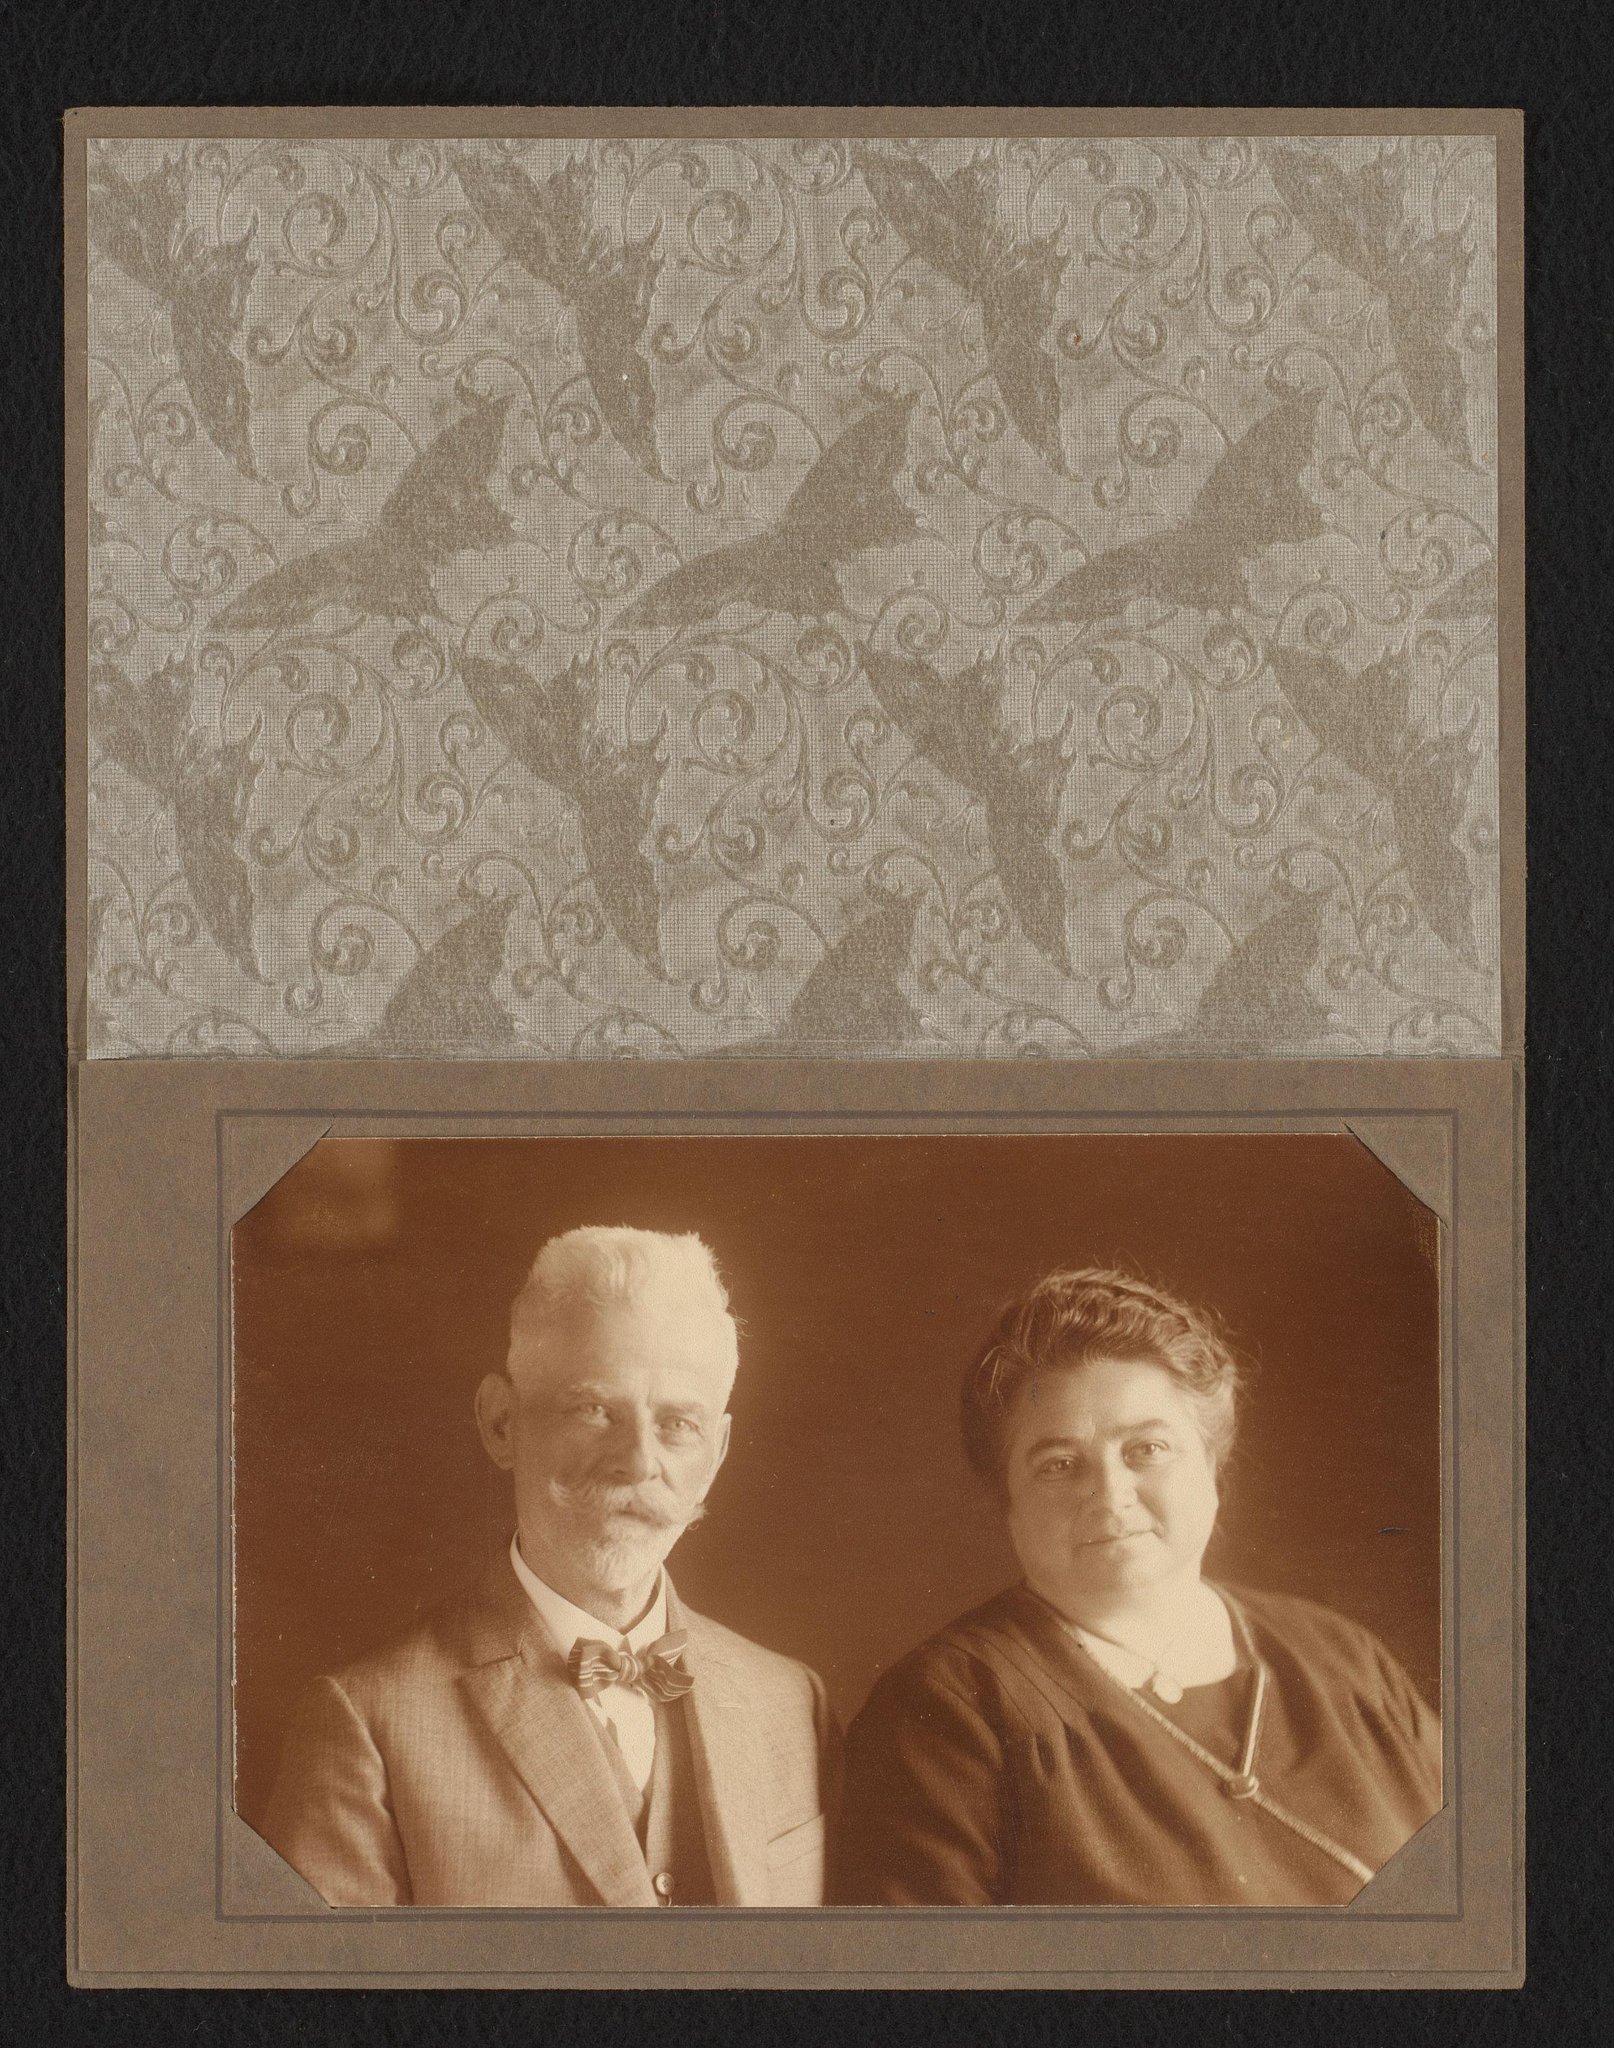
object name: photograph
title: Portret van een man en een vrouw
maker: Anonymous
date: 1880-1920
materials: cardboard, paper, photographic support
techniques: collodion silver print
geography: netherlands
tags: historical persons - bb - woman, historical persons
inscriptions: name: ‘fam. [R]uykman’